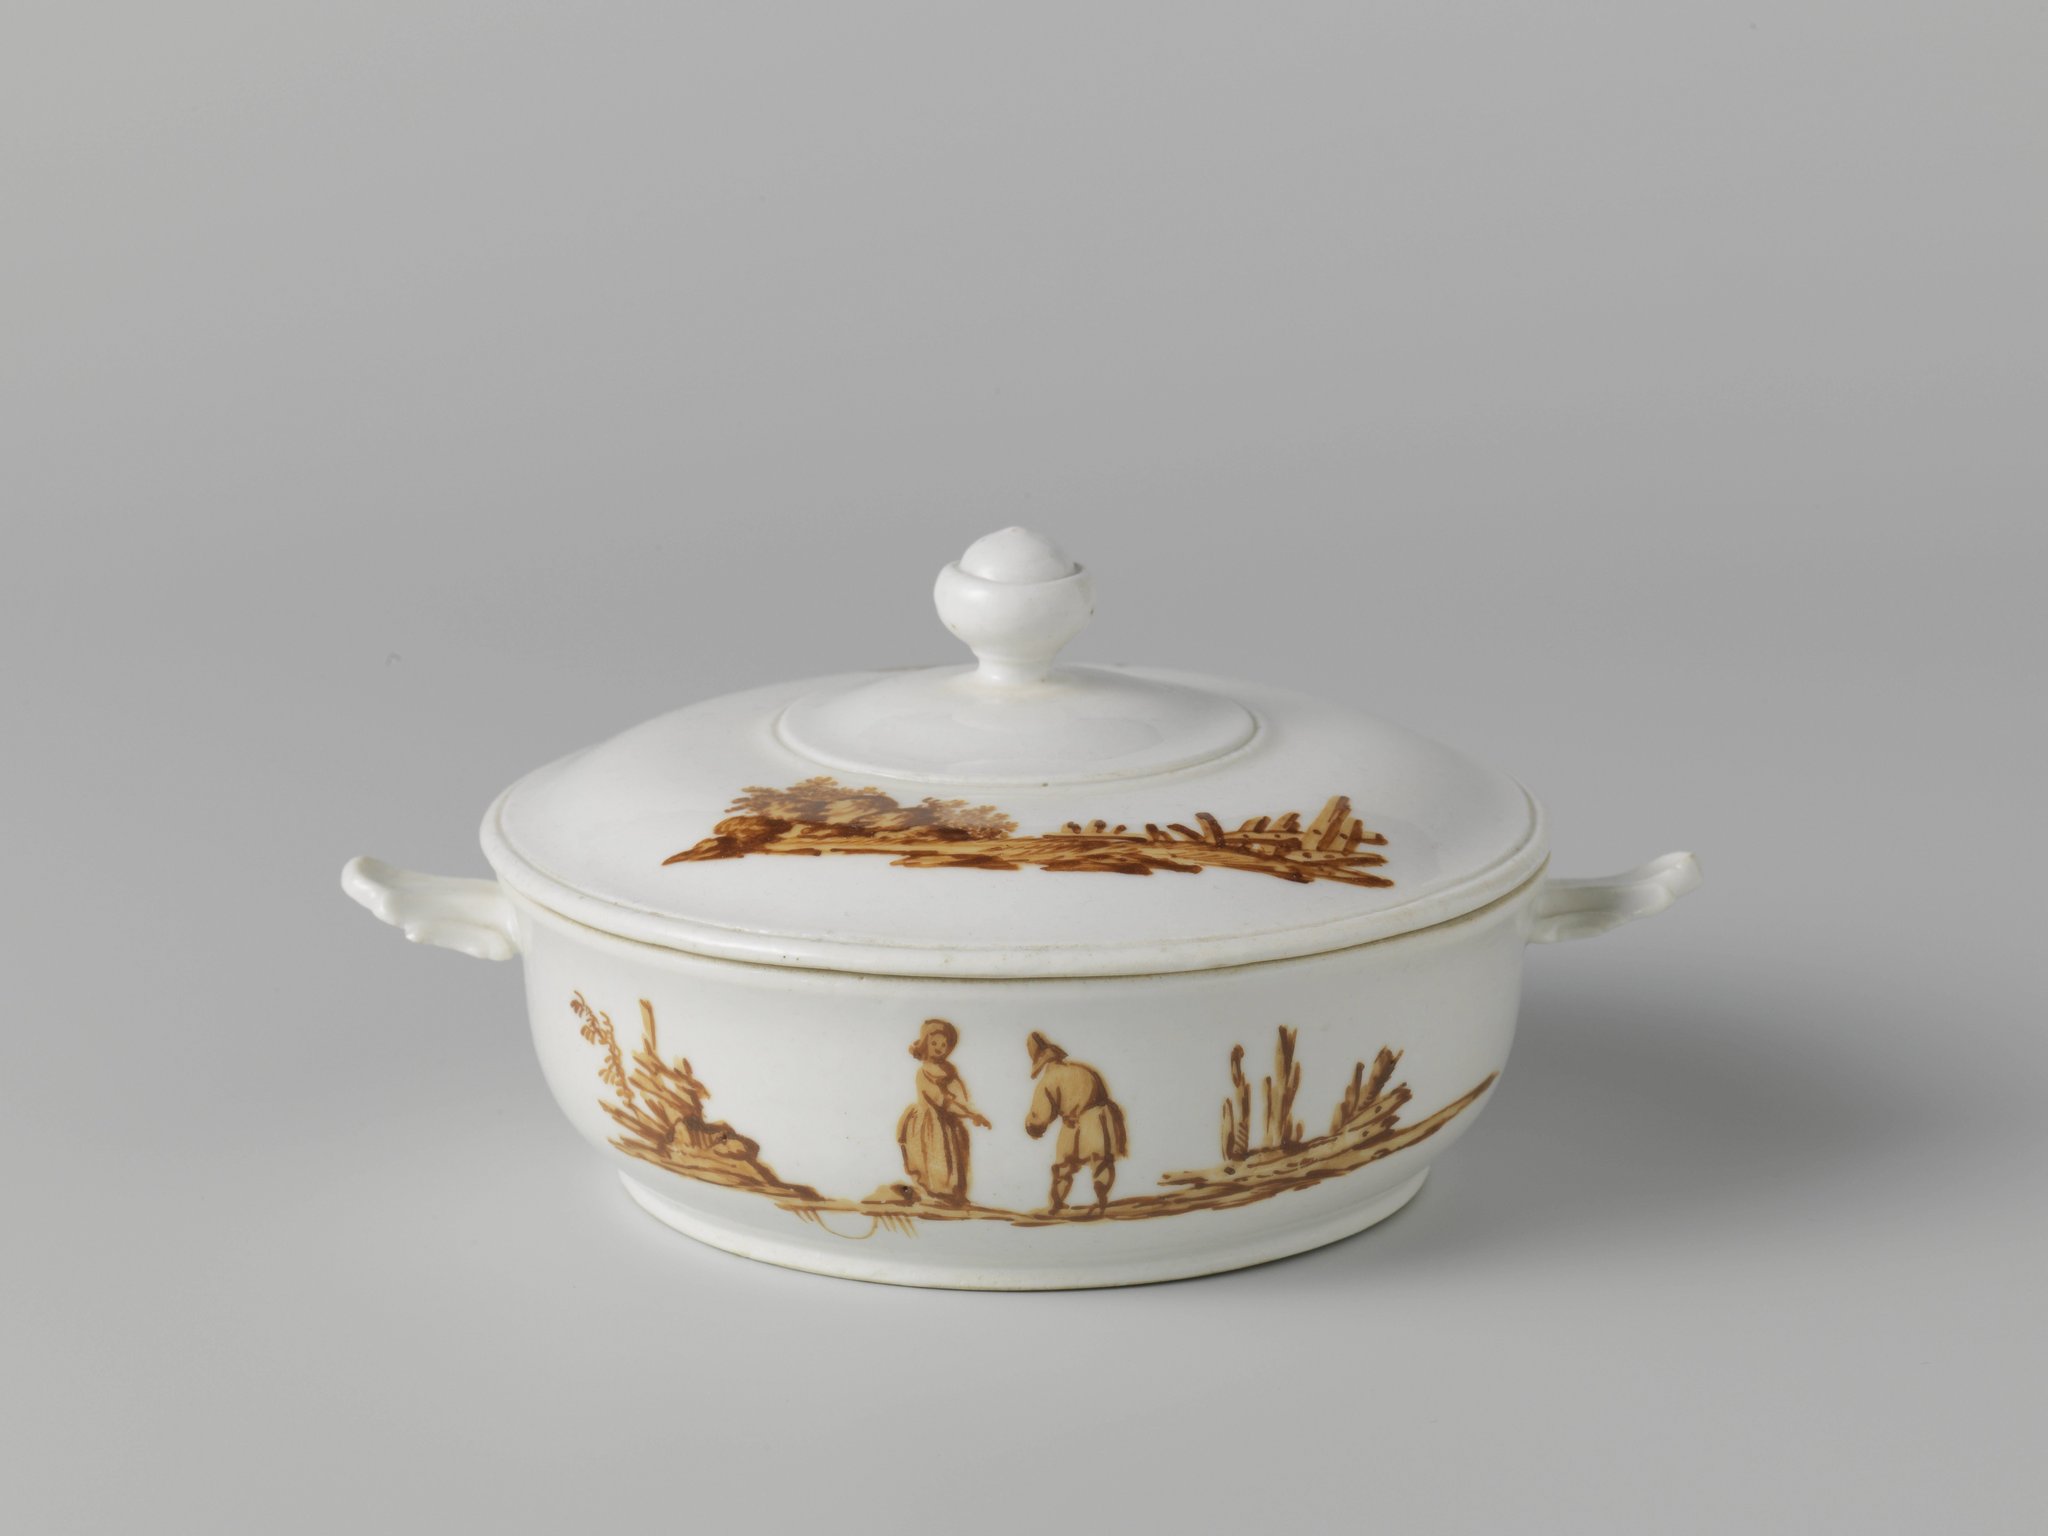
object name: butter dish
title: Botervloot, beschilderd met landschappen met figuren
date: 1774-1778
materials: porcelain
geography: loosdrecht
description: Two butter dishes. Porcelain. Loosdrecht, c. 1774 - 1778. Factory of Joannes de Mol.